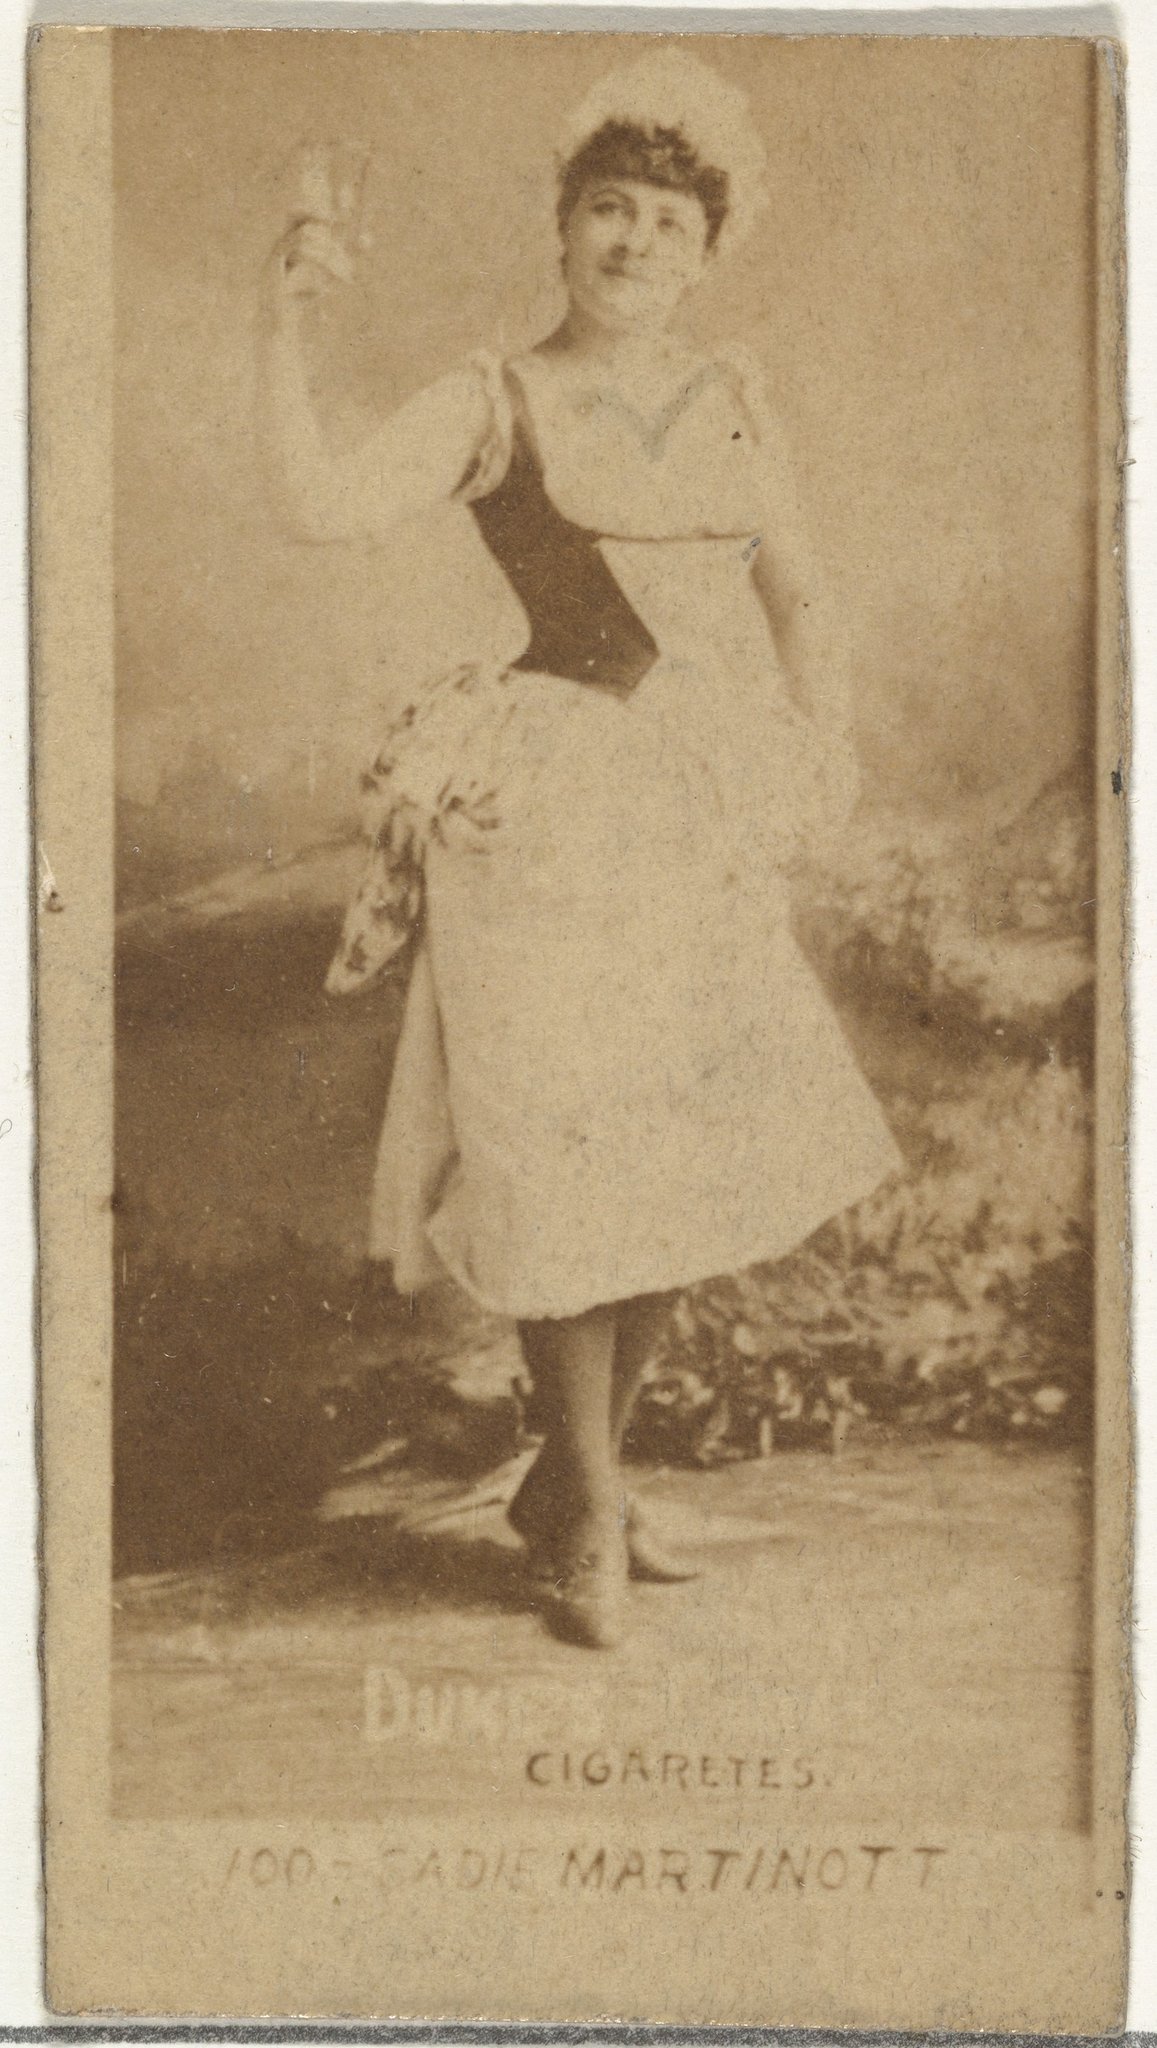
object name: photograph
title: Card Number 100, Sadie Martinot, from the Actors and Actresses series (N145-6) issued by Duke Sons & Co. to promote Duke Cigarettes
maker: w. duke, sons & co.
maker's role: publisher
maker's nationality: american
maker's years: 1870-1920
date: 1880-1889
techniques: albumen silver print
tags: portraits,women,actresses